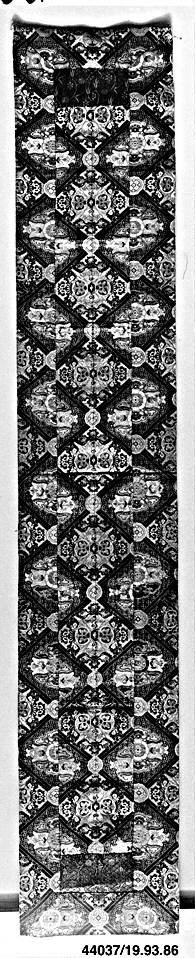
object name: stole, priest's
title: Priest's Stole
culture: japanese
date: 1596-1615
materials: metal thread, silk